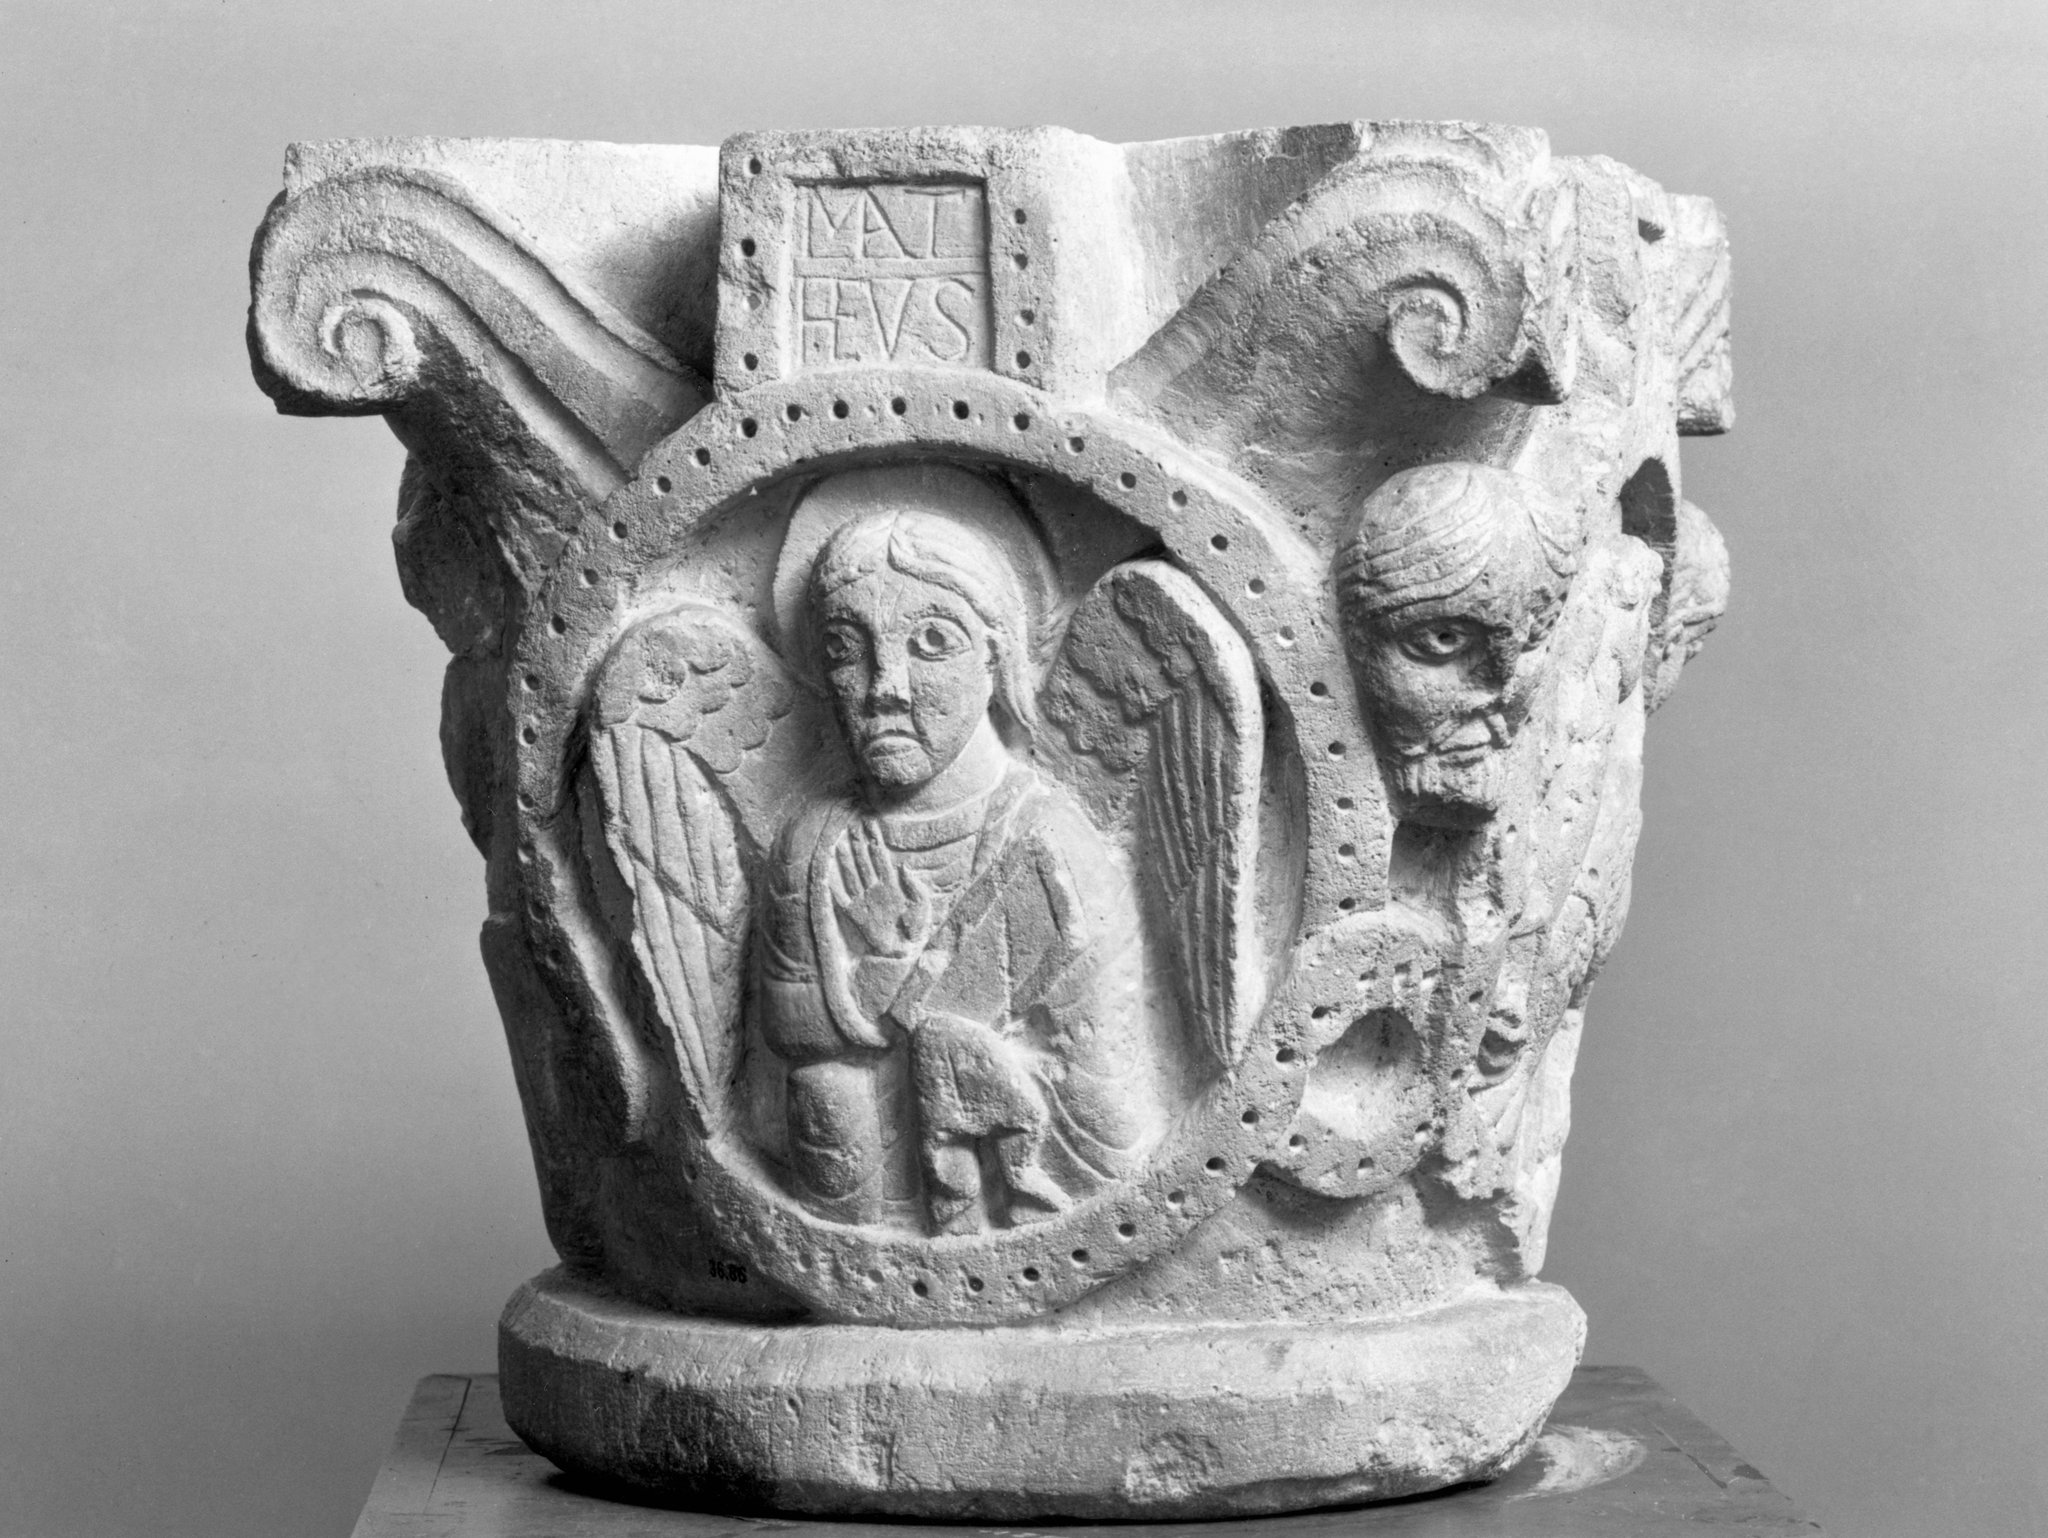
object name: capital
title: Capital with Symbols of the Evangelists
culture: french or spanish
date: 1101-1200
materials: limestone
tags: angels